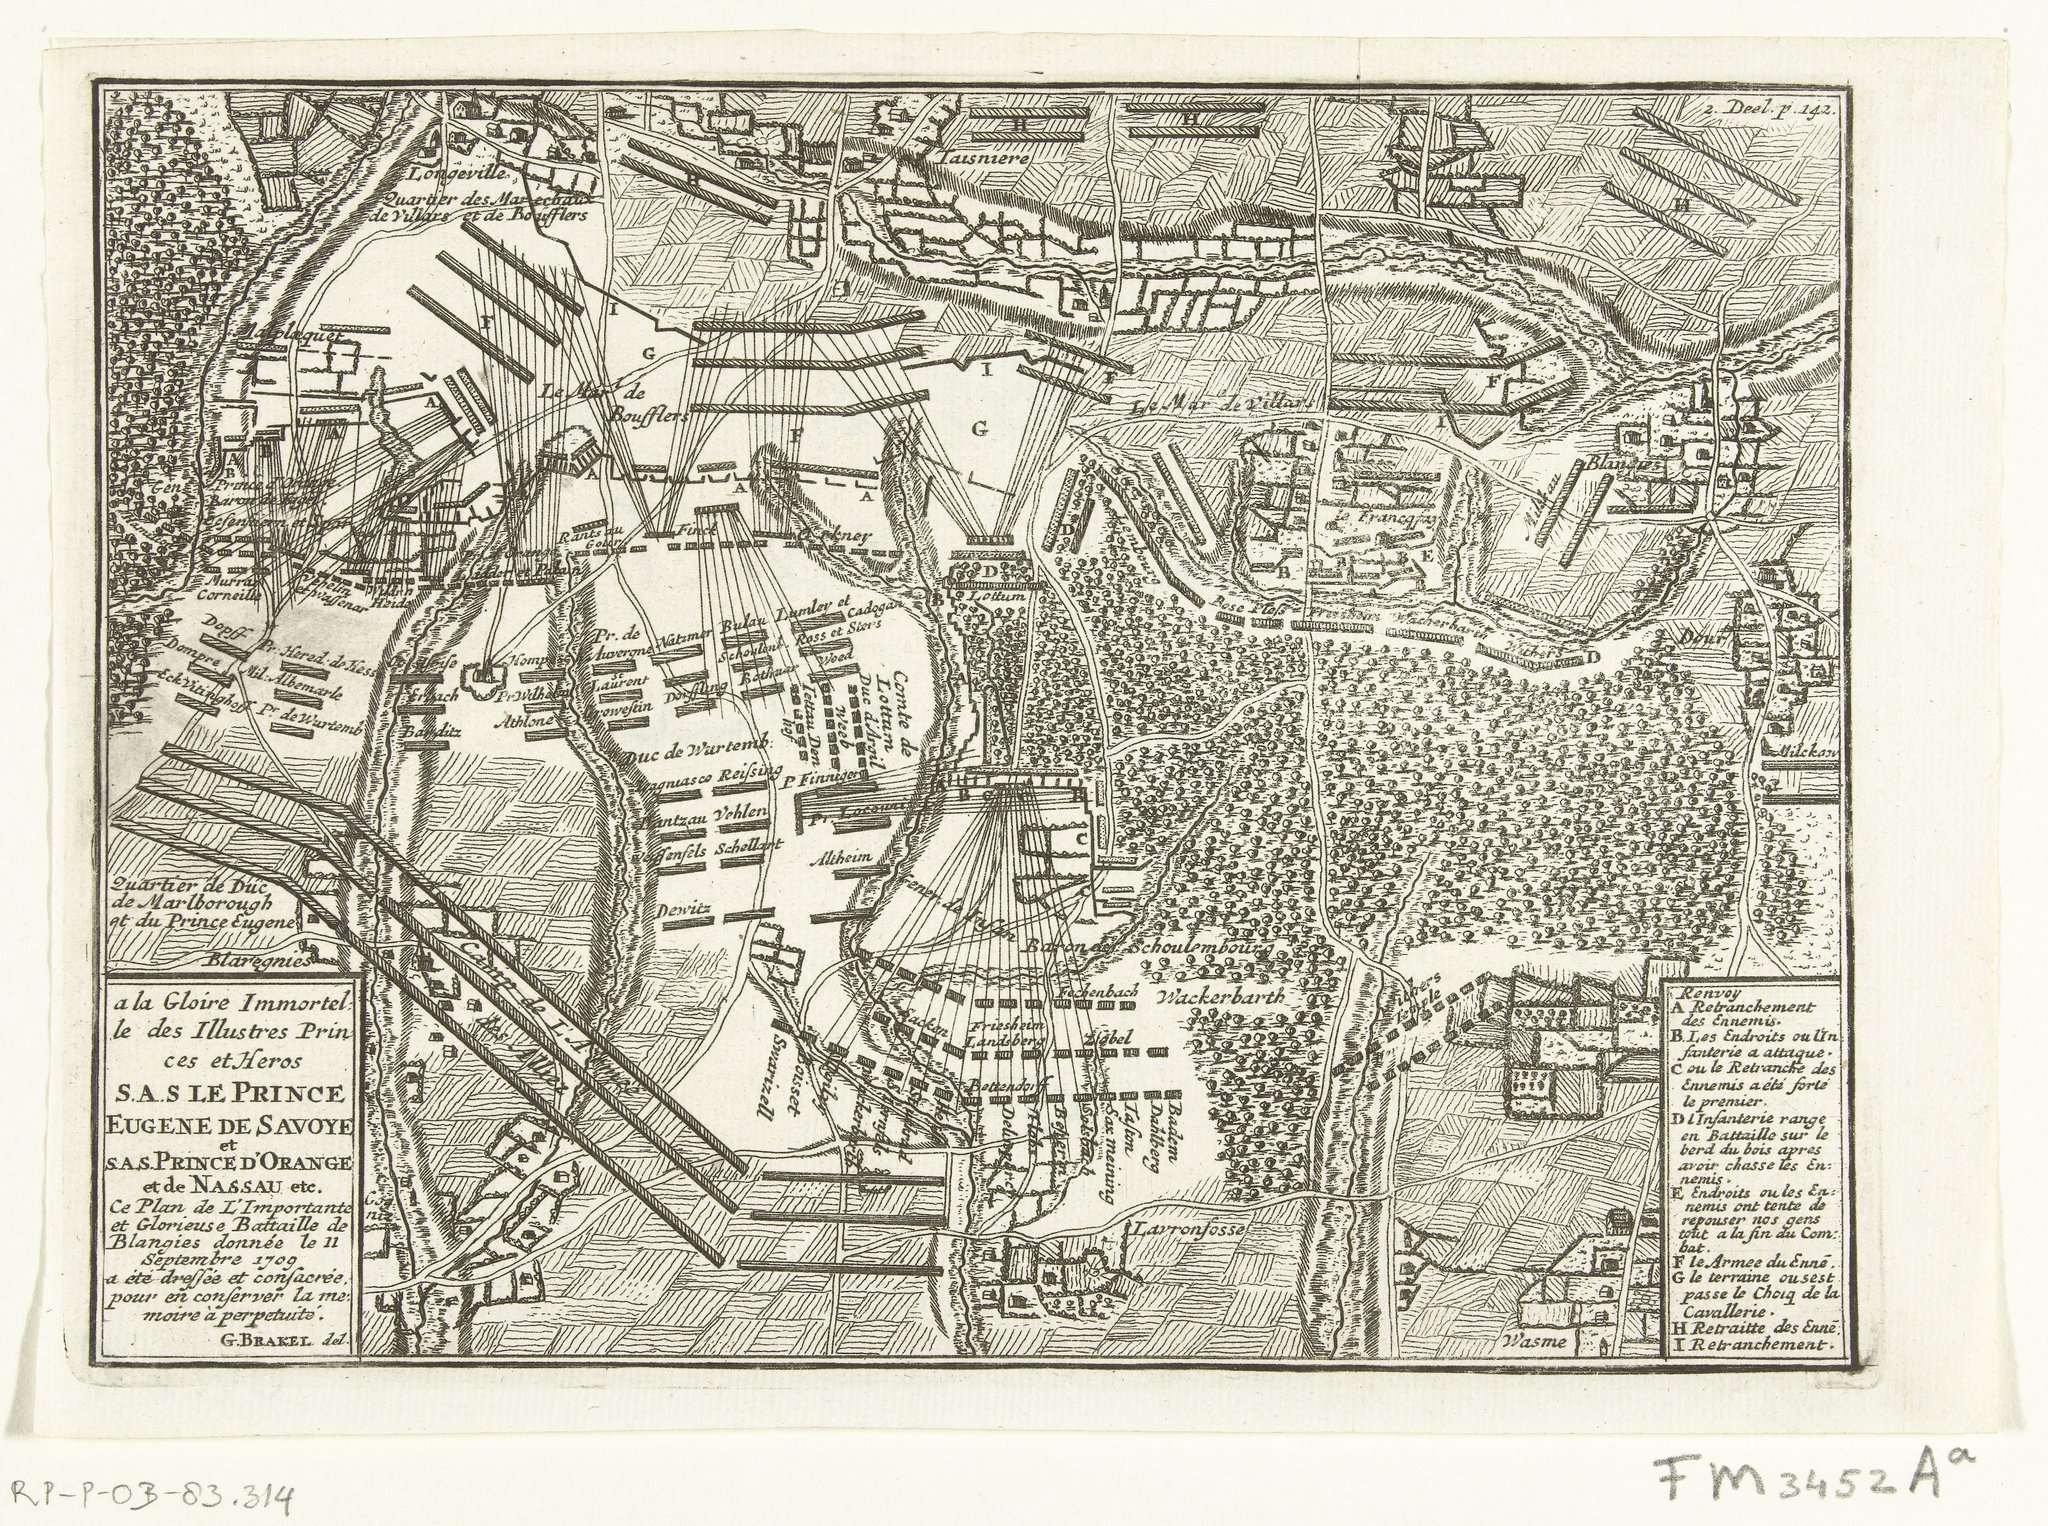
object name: print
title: Slag bij Malplaquet, 1709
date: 1714-1716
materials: paper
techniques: etching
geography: northern netherlands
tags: johan willem friso (prins van oranje-nassau), maps of separate countries or regions, battle (+ land forces)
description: Gebruikt als illustratie in: F. Halma en I. Lamige, Het leven van Zyne Hoogheit Johan Willem Friso... nevens de historie van den jongstleden oorlog : met de grondttekeningen der voornaamste steden en vestingen, Johannes van Oosterwyk, Amsterdam 1716. Dit nummer is een door het RPK toegevoegd nummer en staat niet in Frederik Muller, het werk waar de prent voor is gemaakt of uit afkomstig is, staat wel vermeld in Frederik Muller.